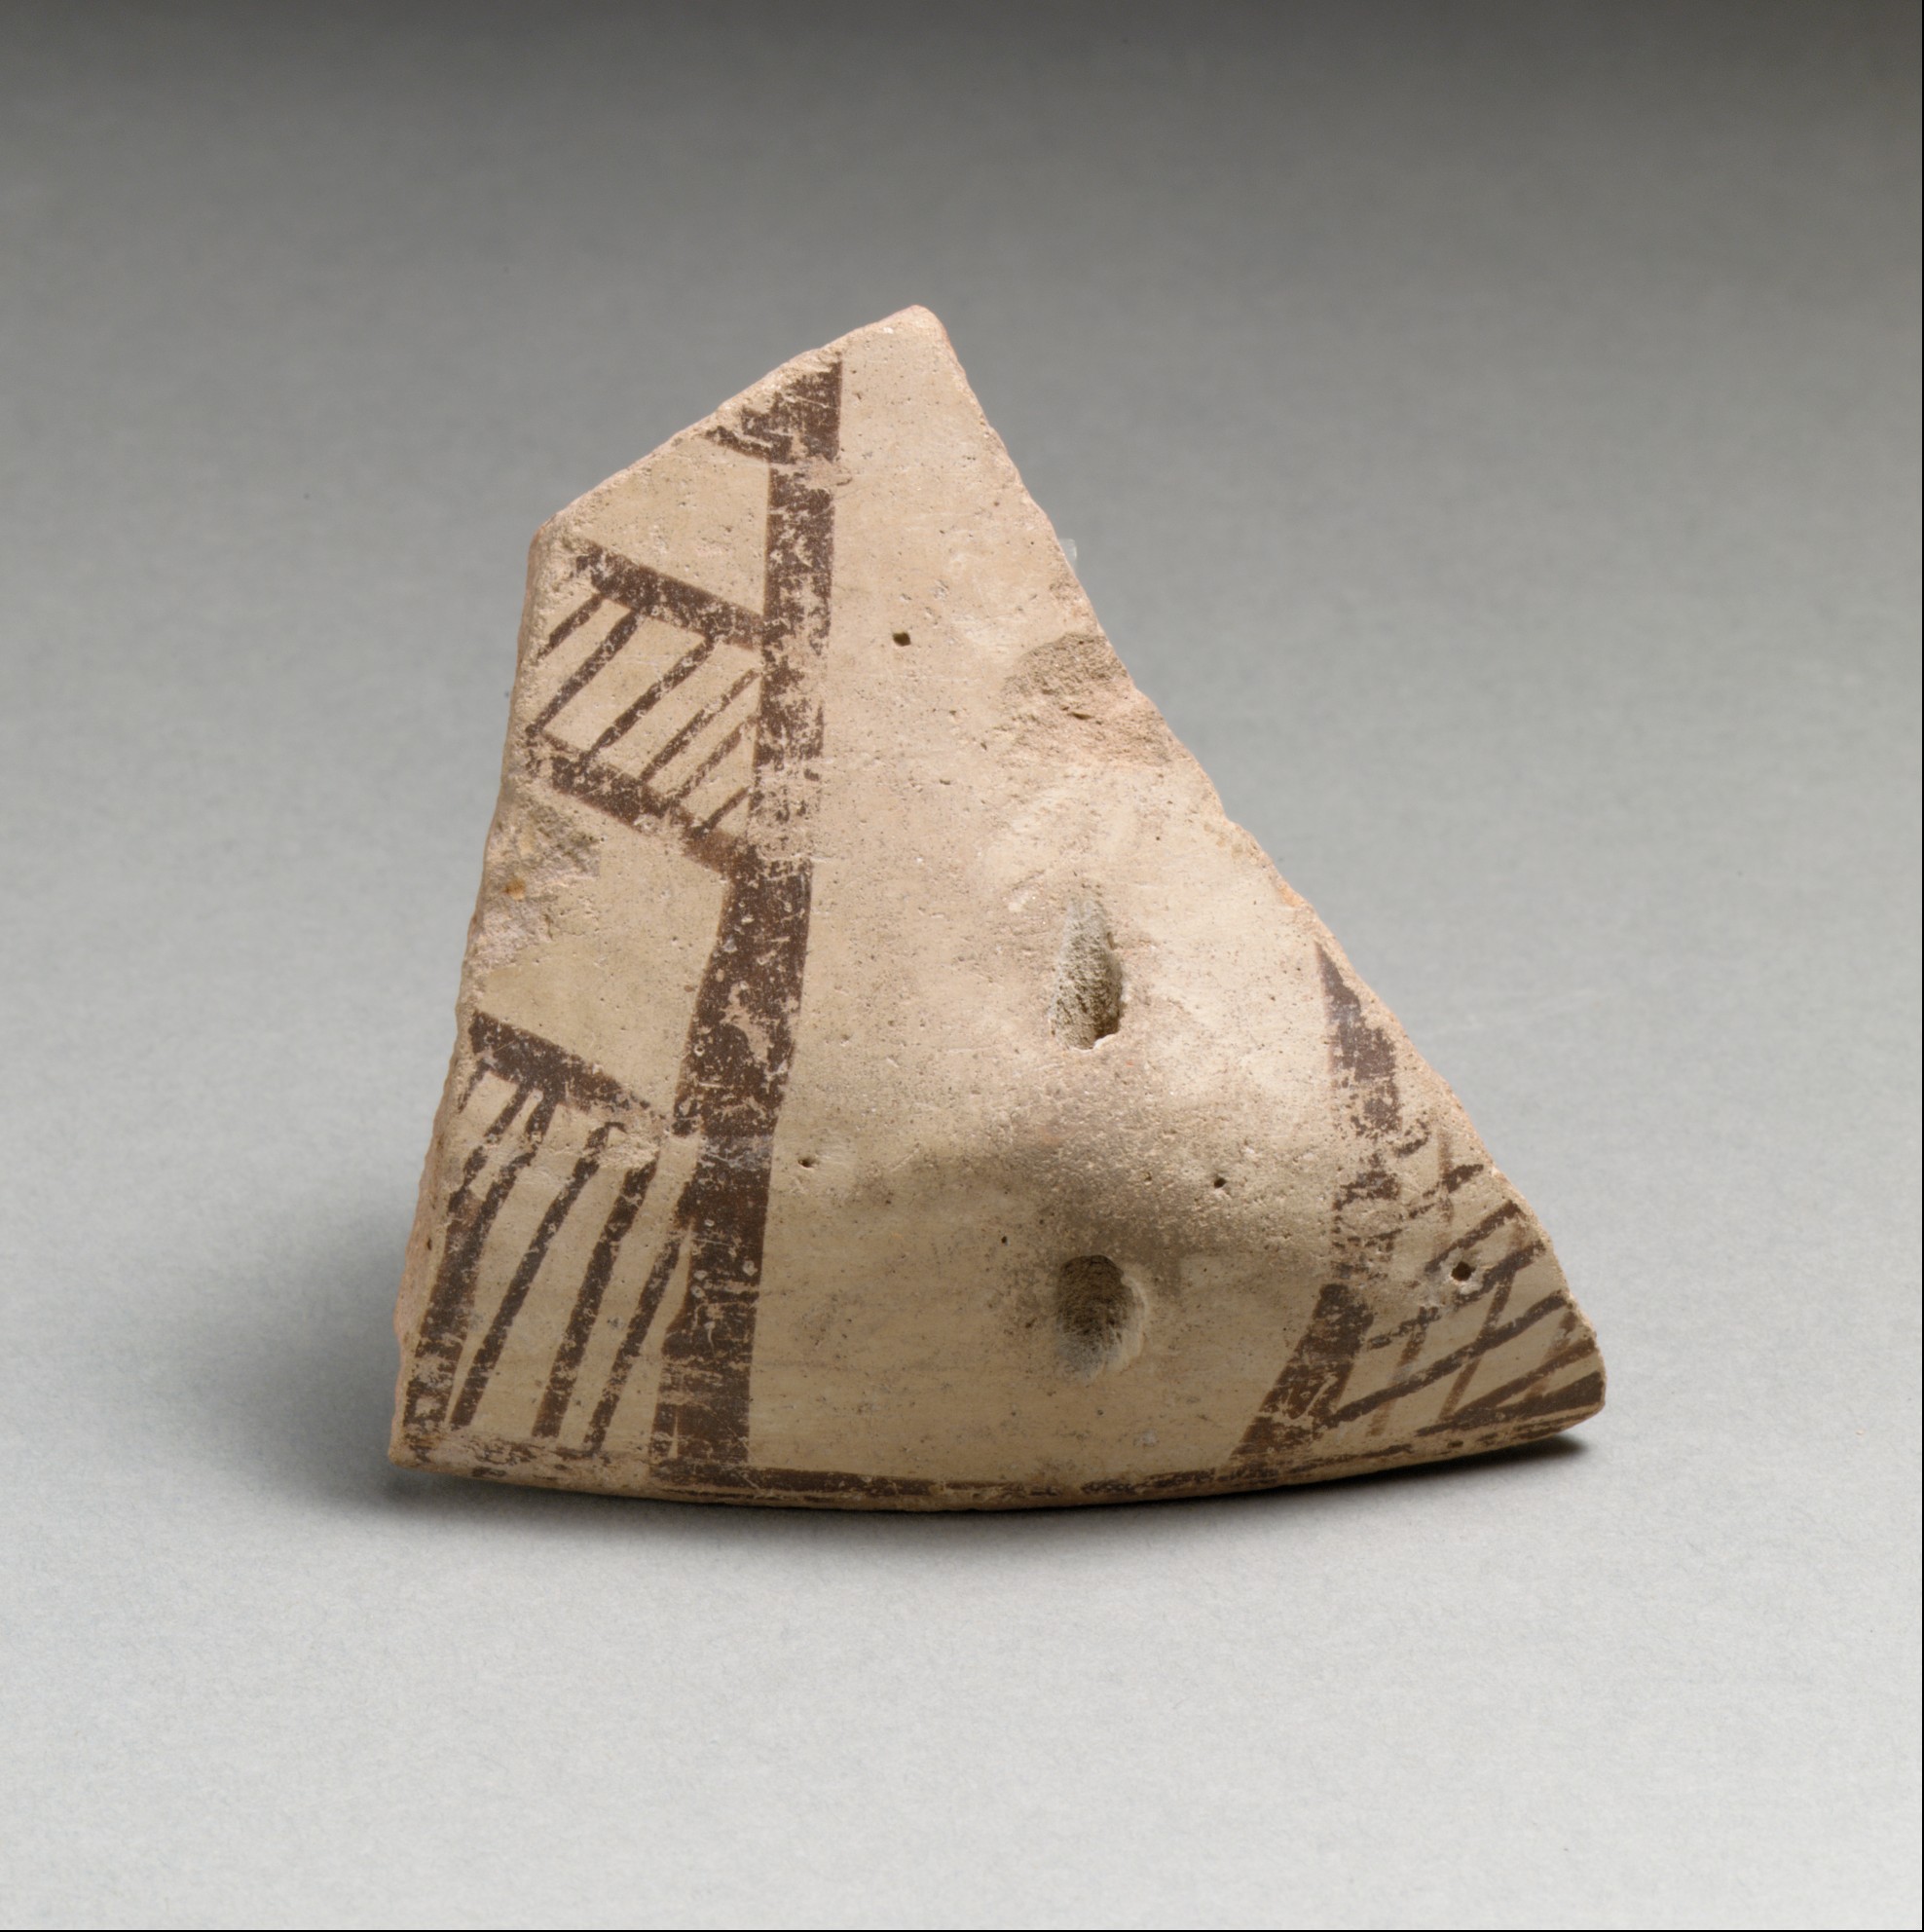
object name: vase fragment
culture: neolithic, thessaly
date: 4000-3000 BCE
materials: terracotta